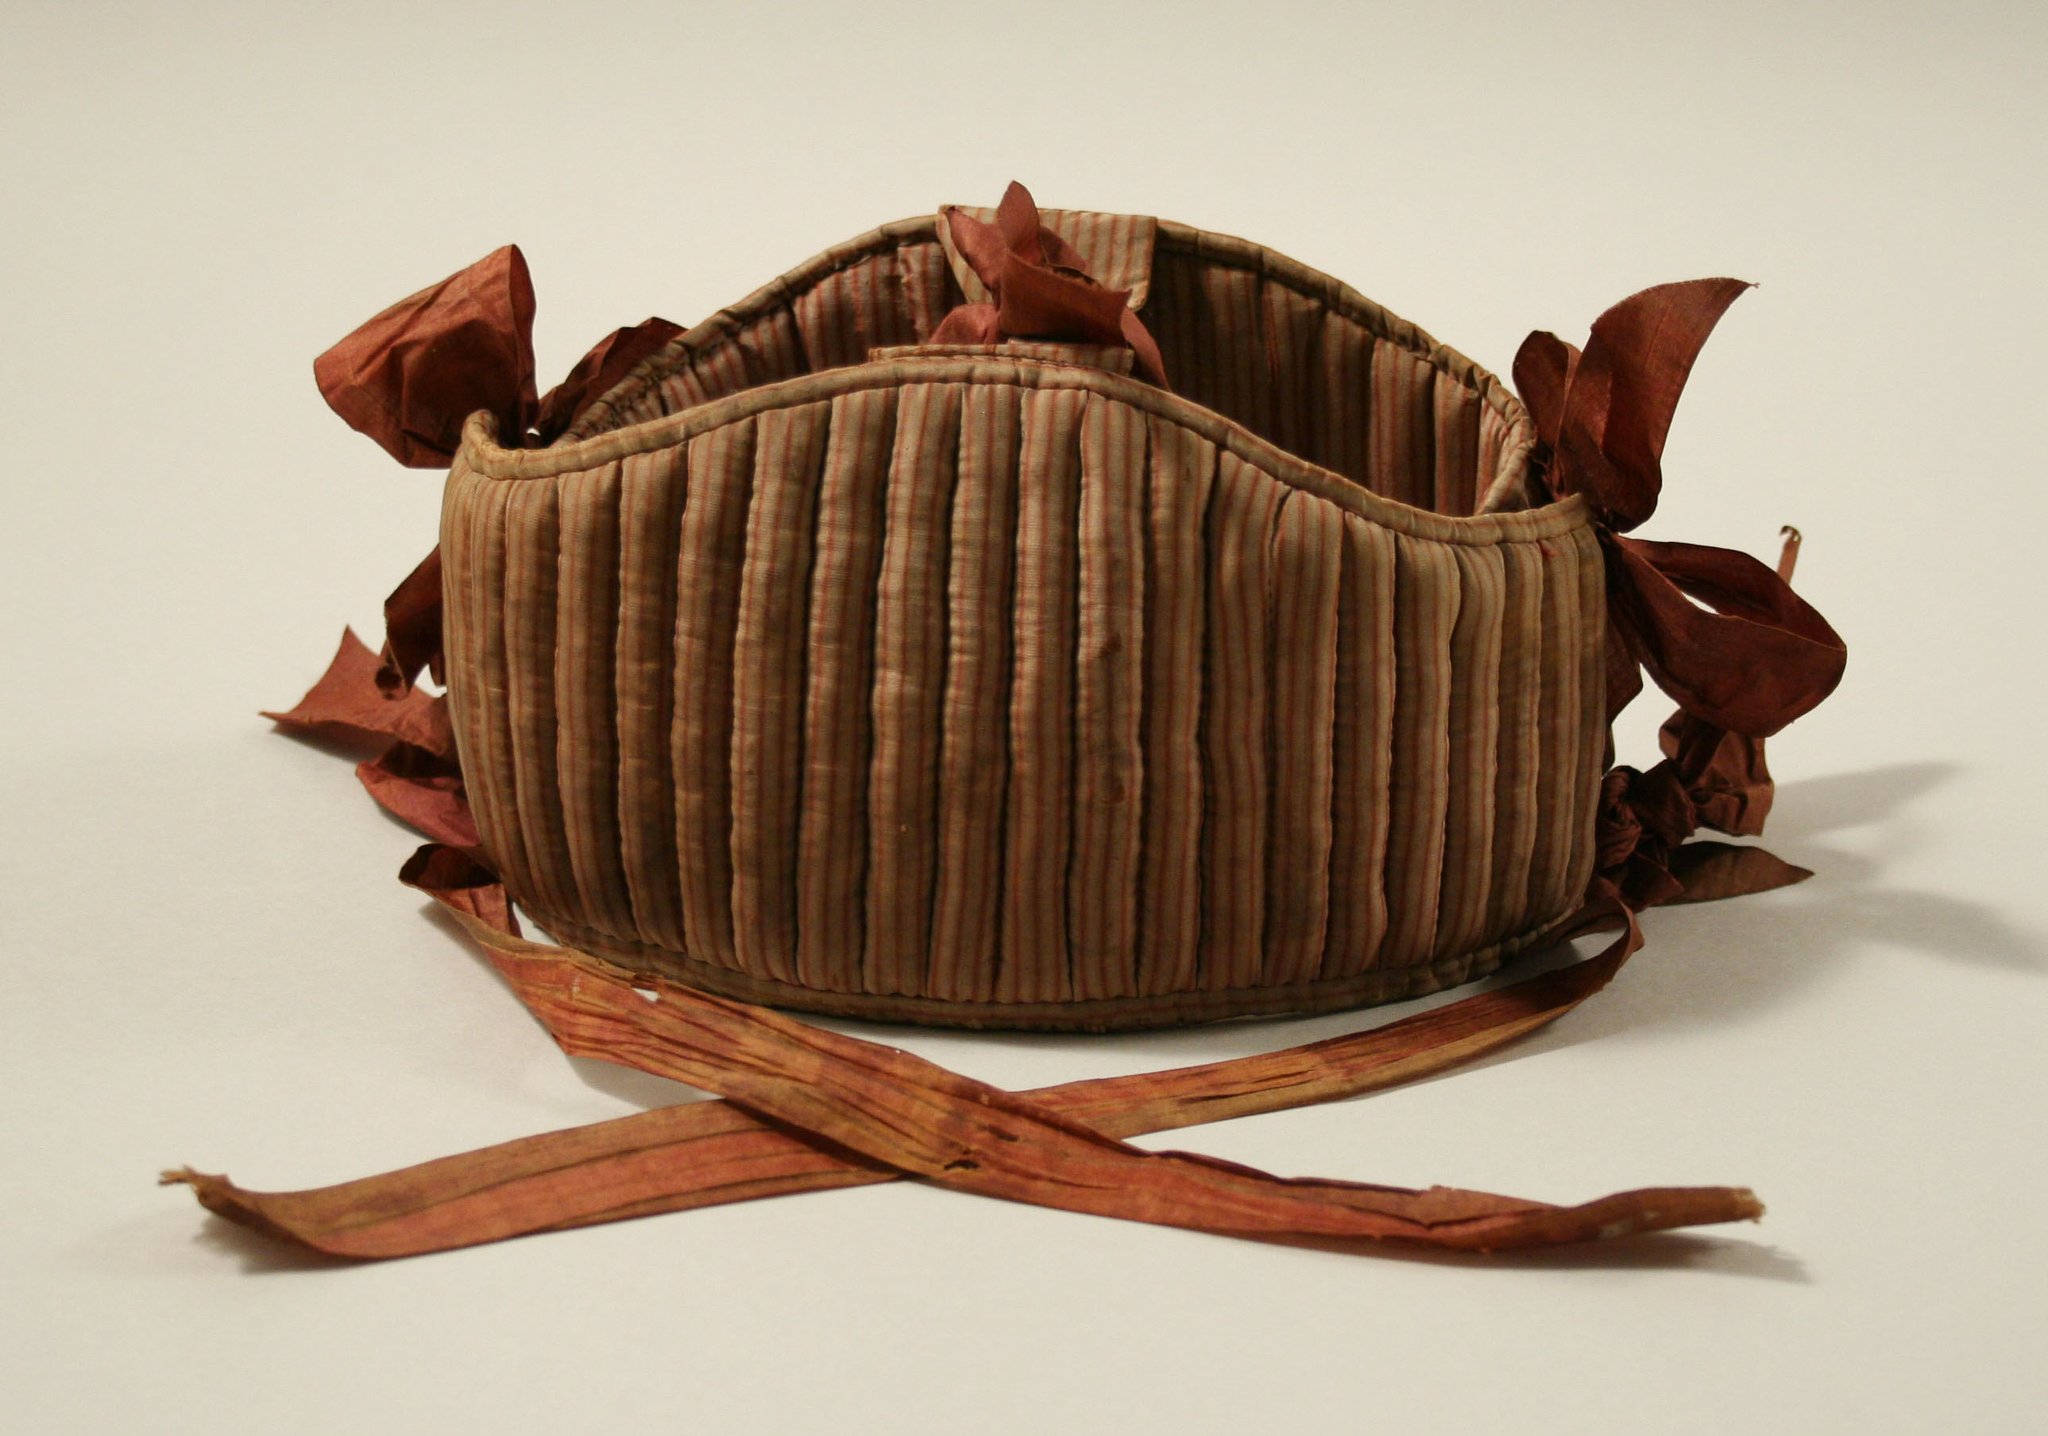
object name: head protector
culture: swiss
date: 1767-1800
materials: silk